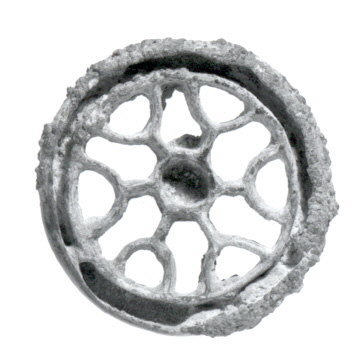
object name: stamp seal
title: Compartmented stamp seal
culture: bactria-margiana archaeological complex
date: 2333-1668 BCE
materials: copper alloy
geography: bactria-margiana